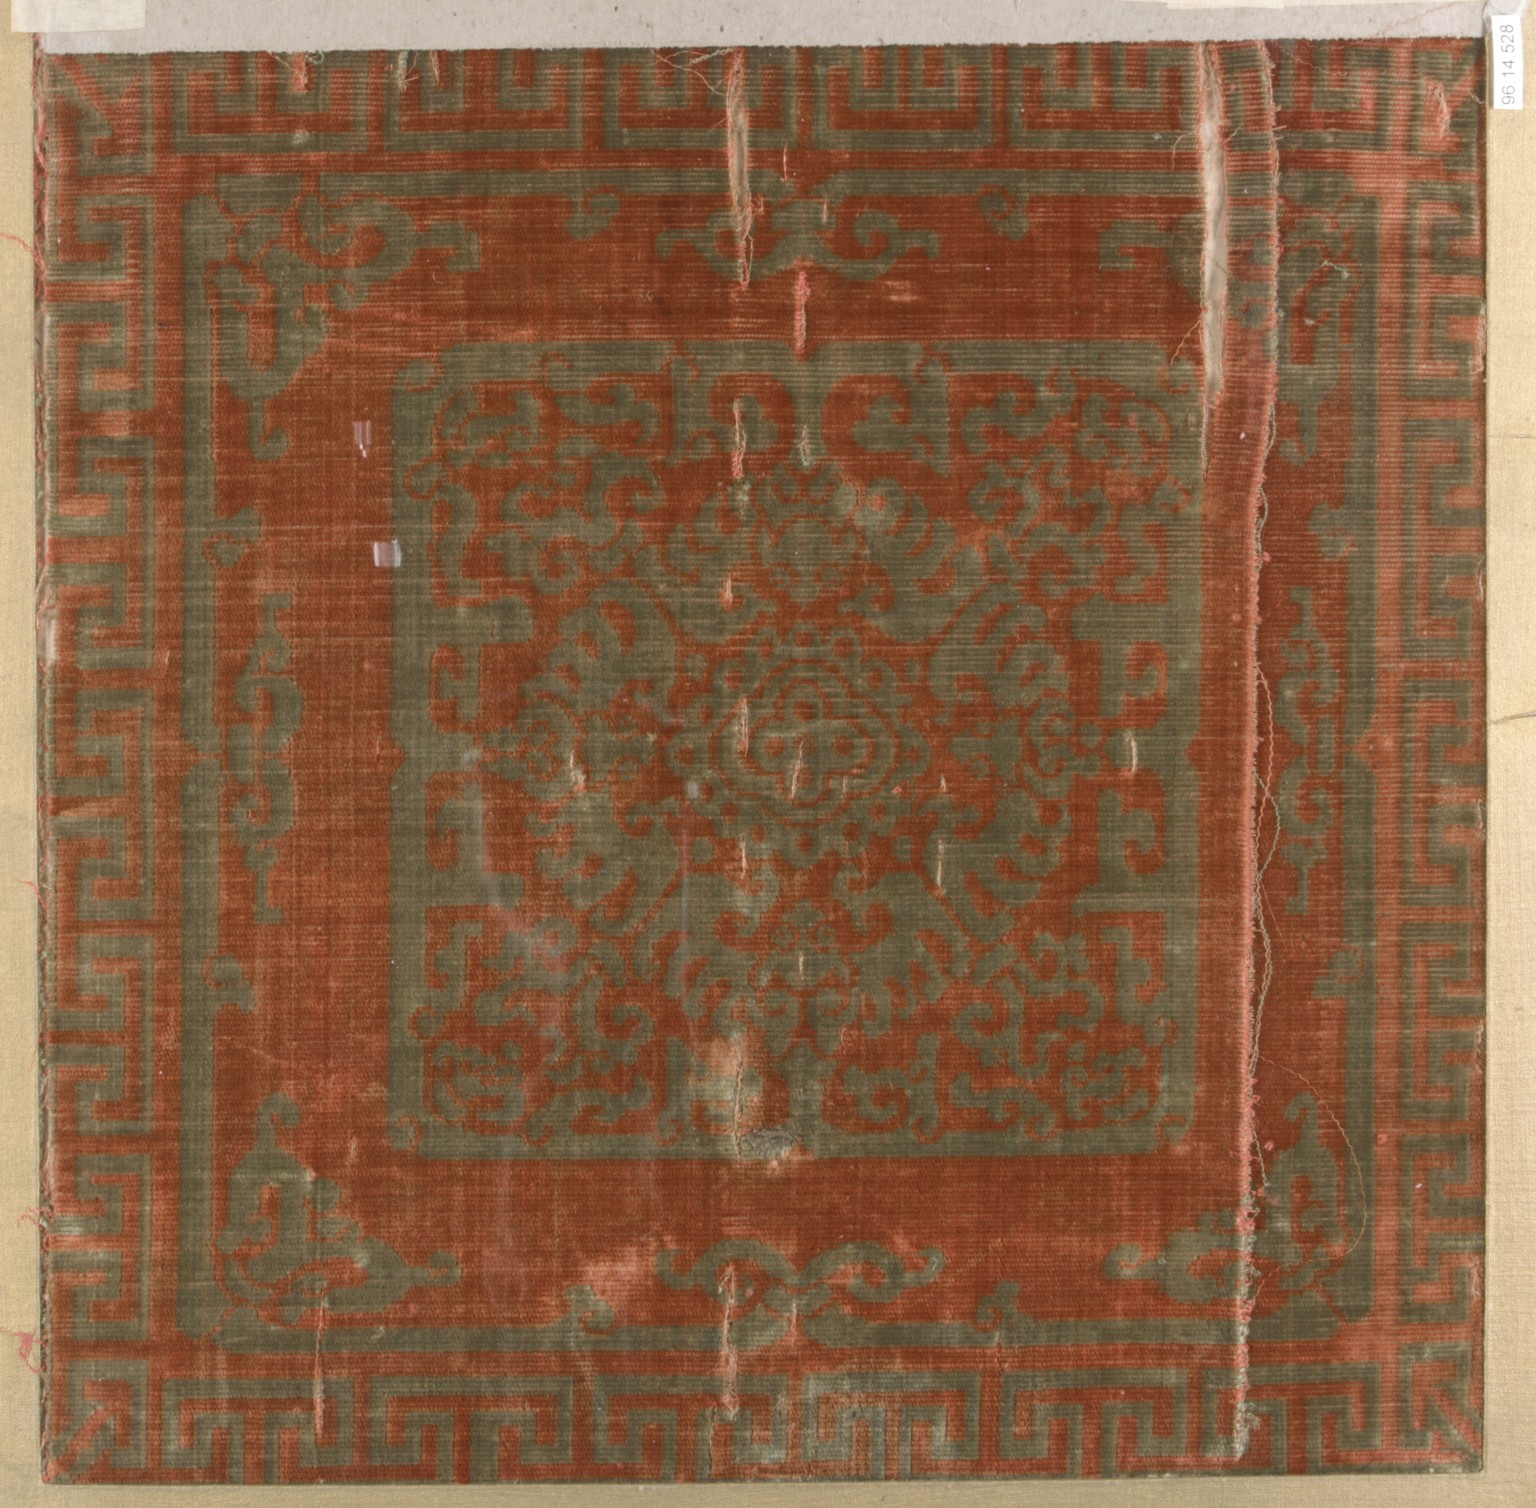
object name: piece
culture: chinese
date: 1701-1900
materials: silk